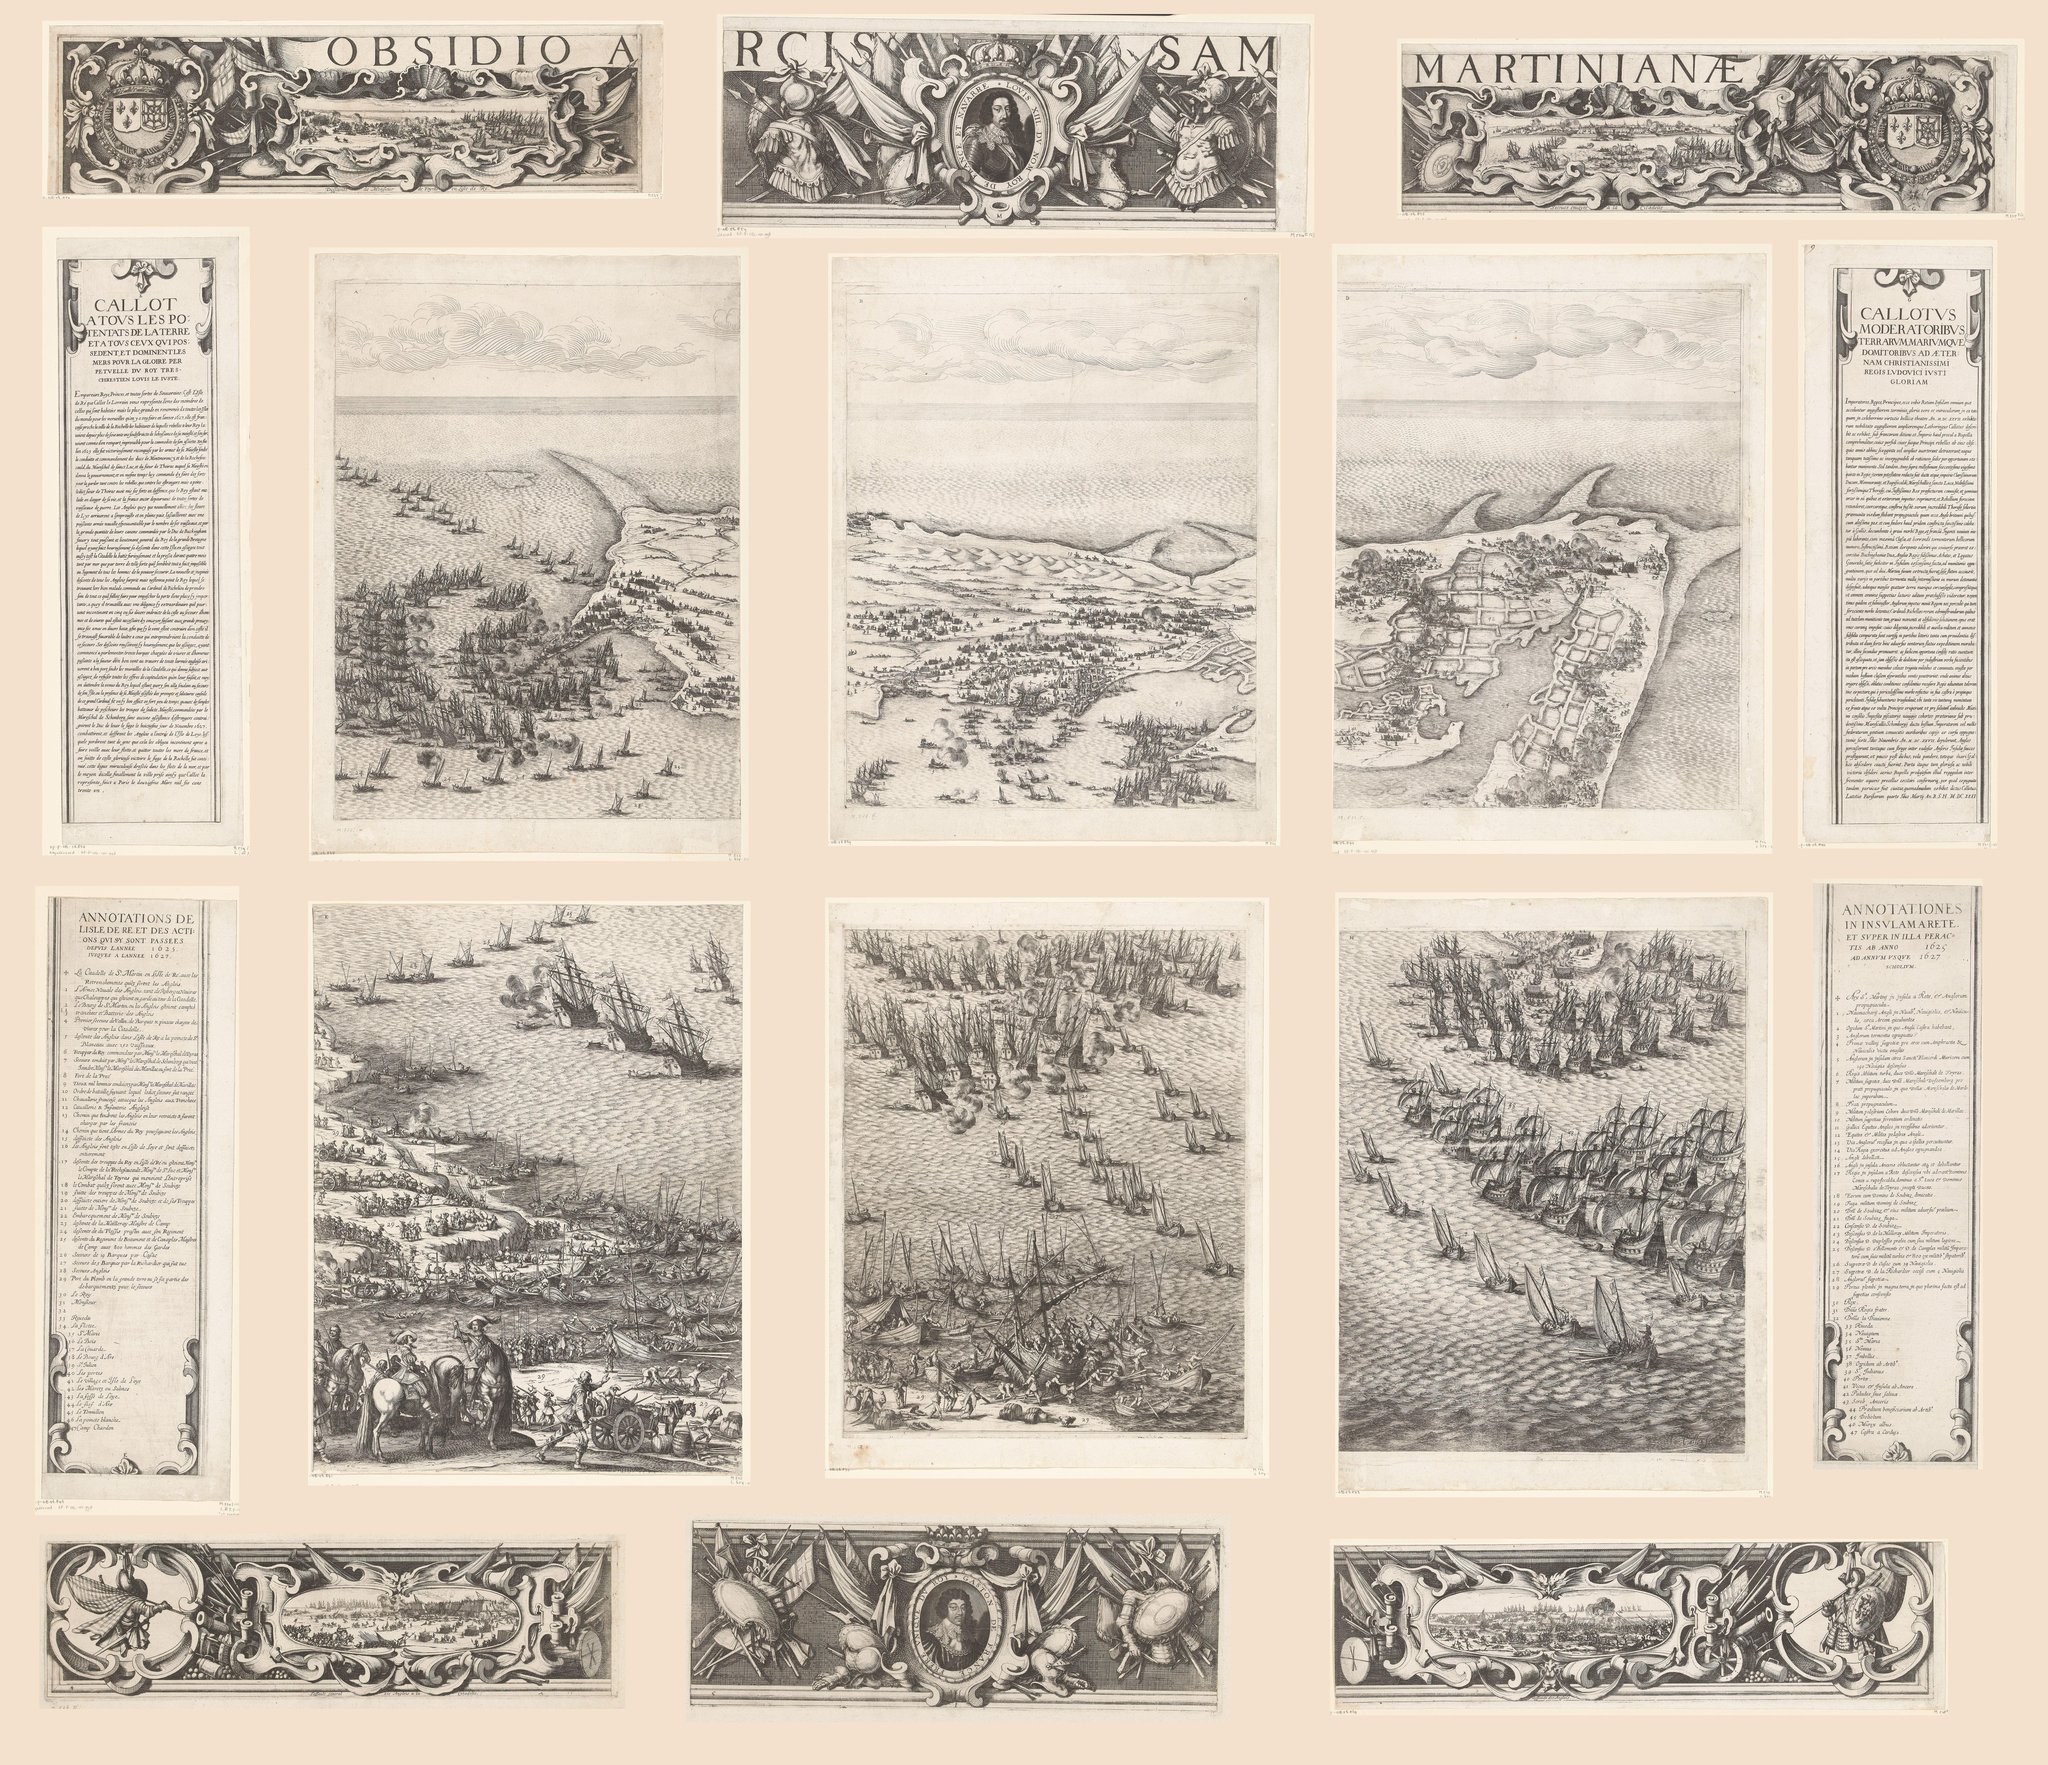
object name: history print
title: Beleg van Saint Martin op het Île de Ré, juli-november 1627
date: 1629-1631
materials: paper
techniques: engraving, etching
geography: paris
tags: gaston jean-baptiste hertog van orléans, lodewijk xiii (koning van frankrijk), maps of separate countries or regions, historical persons, battle, ships (in general), attack ~ siege, warfare; military affairs (+ naval force), ornament ~ cartouche, fortified city, siege, armorial bearing, heraldry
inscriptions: collector's mark: Lugt 240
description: Prent, bestaand uit 16 bladen, van het beleg van de citadel Saint Martin op het Île de Ré in 1627, dat werd uitgevoerd door Engelse troepen onder leiding van de hertog van Buckingham en werd beëindigd door Franse troepen onder leiding van kardinaal Richelieu. Centraal staat een cartografische weergave van het eiland voor de Franse kust, waarop en waaromheen het wemelt van de legertroepen en de schepen. Boven en onder deze centrale kaart twee 'banden' met wapenschilden, portretten en cartouches met episodes uit de strijd om Saint Martin. Links en rechts van de kaart een tekstuele toelichting en legenda in het Frans en het Latijn.